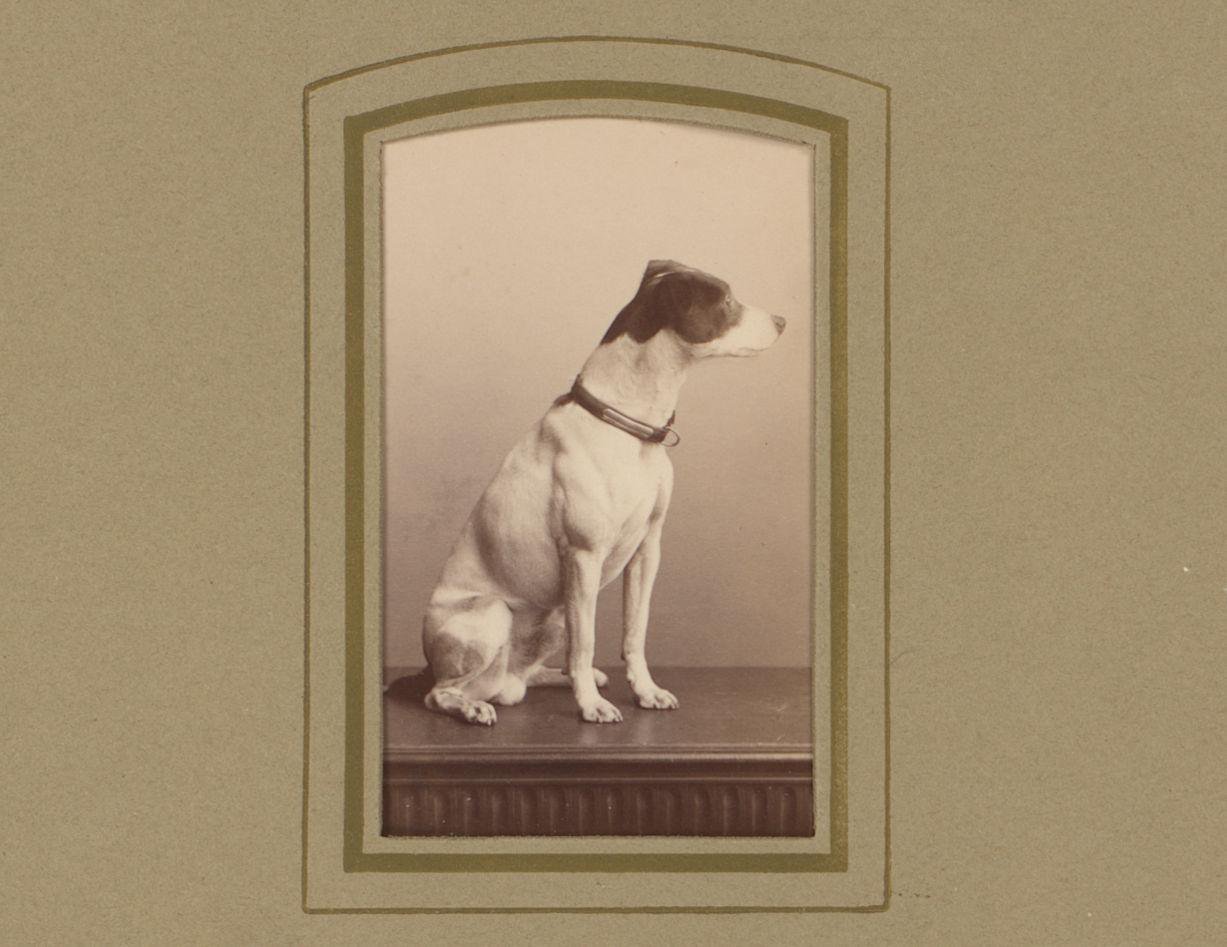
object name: carte de visite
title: Hond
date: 1857-1908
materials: cardboard, photographic support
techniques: albumen print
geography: amsterdam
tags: dog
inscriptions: inscription: ‘Woodbury & Page/ AMSTERDAM/ DAMSTRAAT 23/ EN/ BATAVIA.’